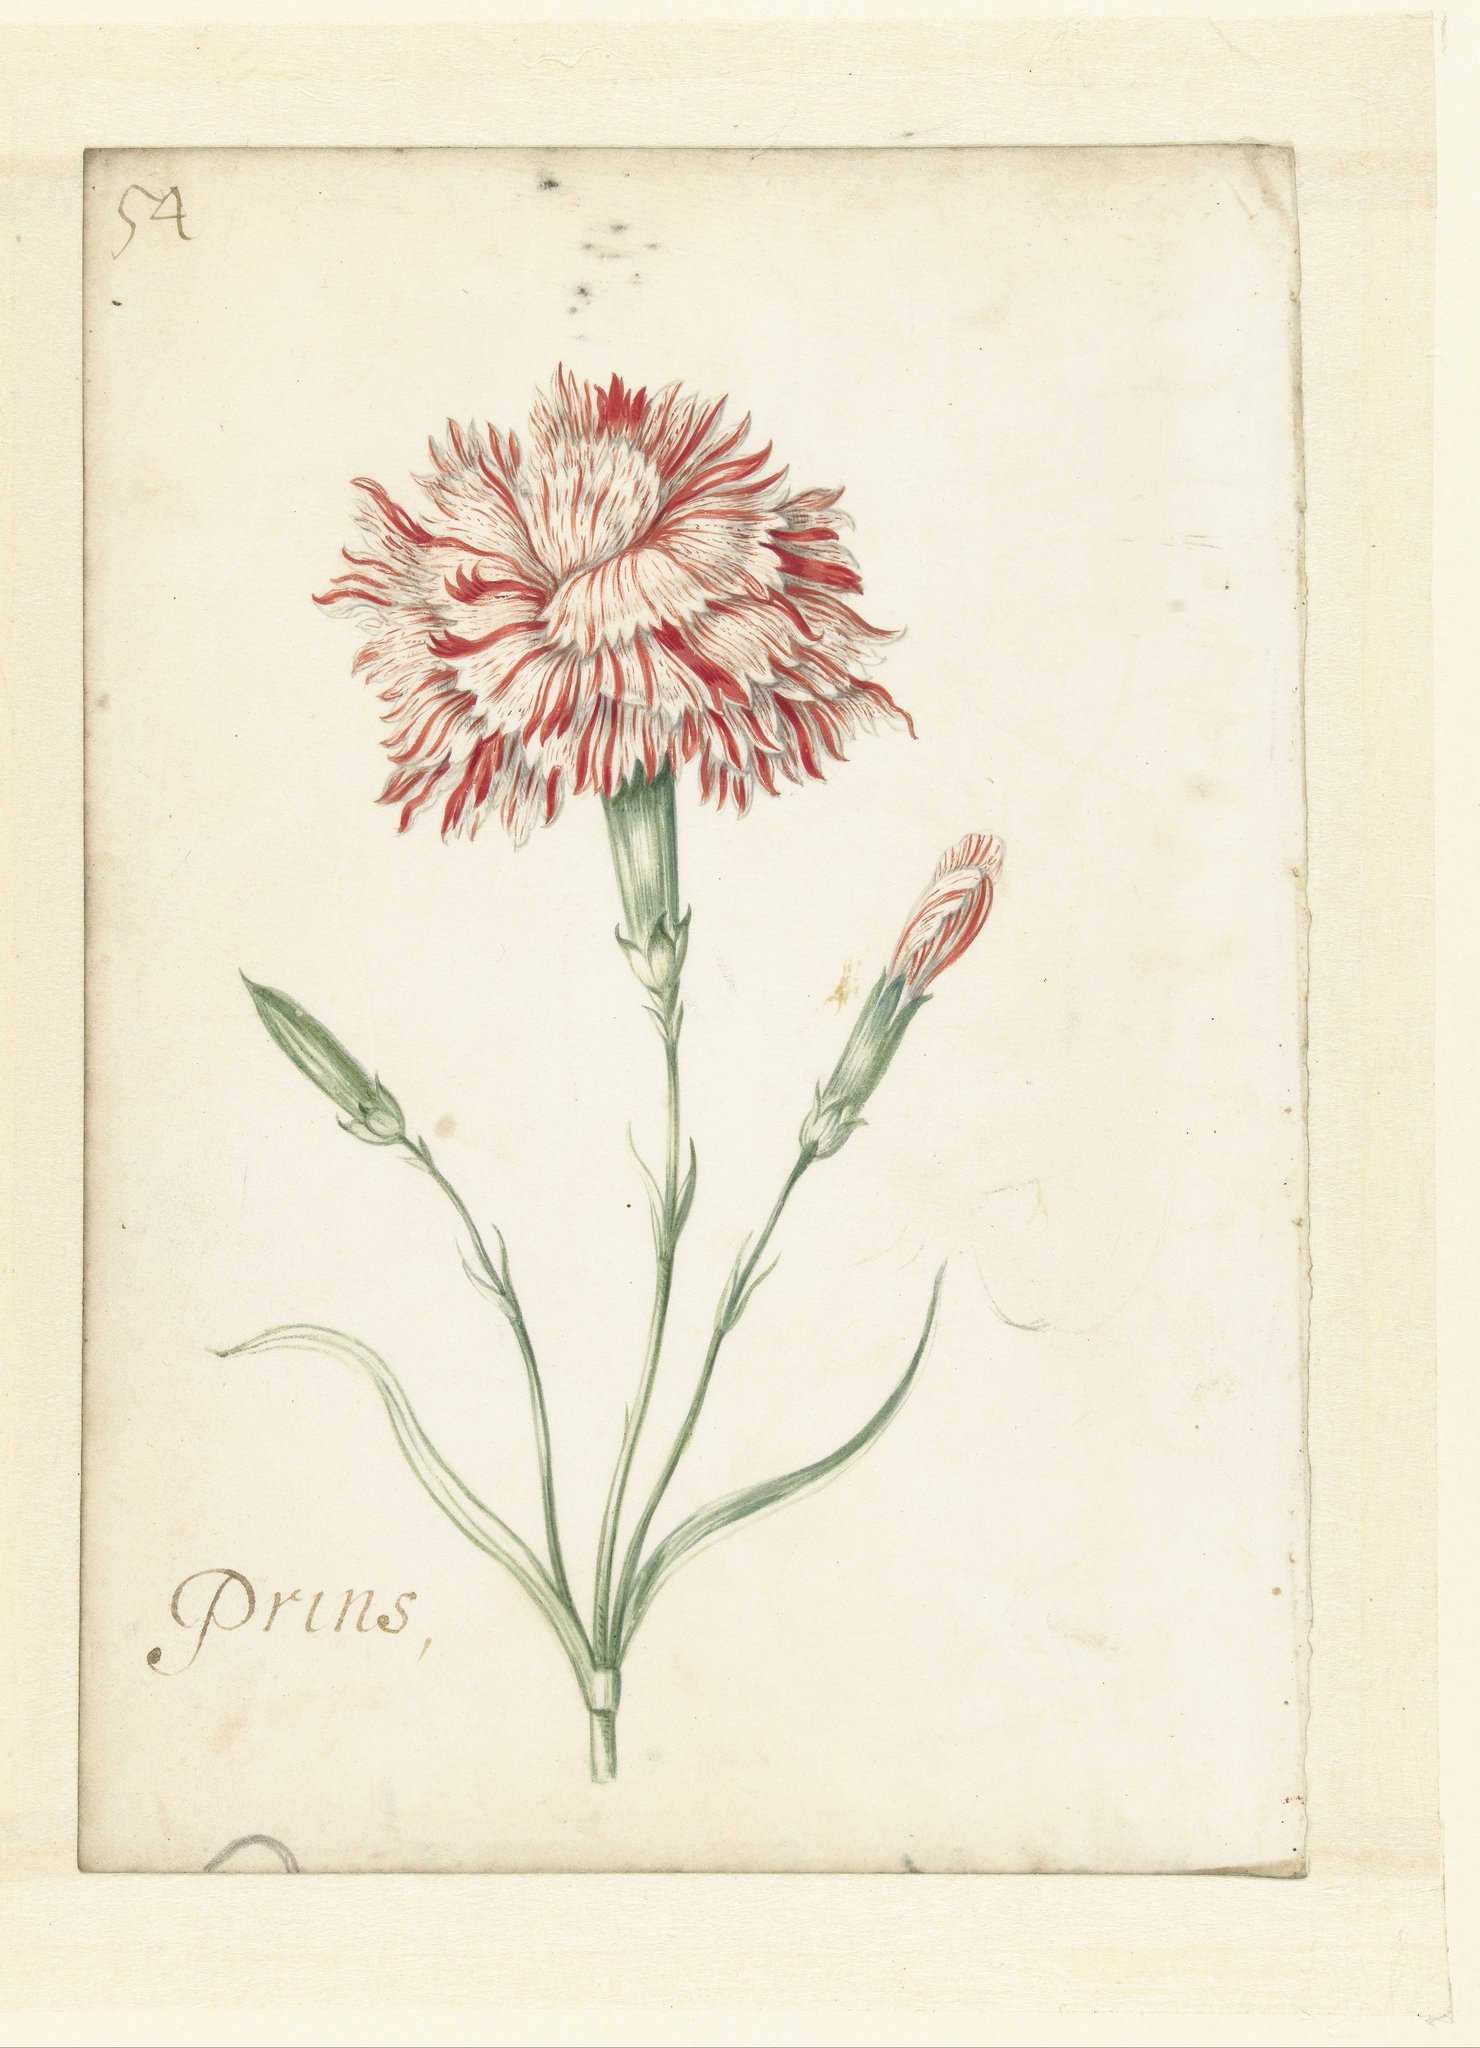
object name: drawing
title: Carnation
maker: jacob marrel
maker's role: draughtsman, painter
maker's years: 1614-1681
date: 1624-1681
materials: parchment, watercolor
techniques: brush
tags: flowers: carnation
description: Anjer, met onderaan de naam van de bloem: Prins.